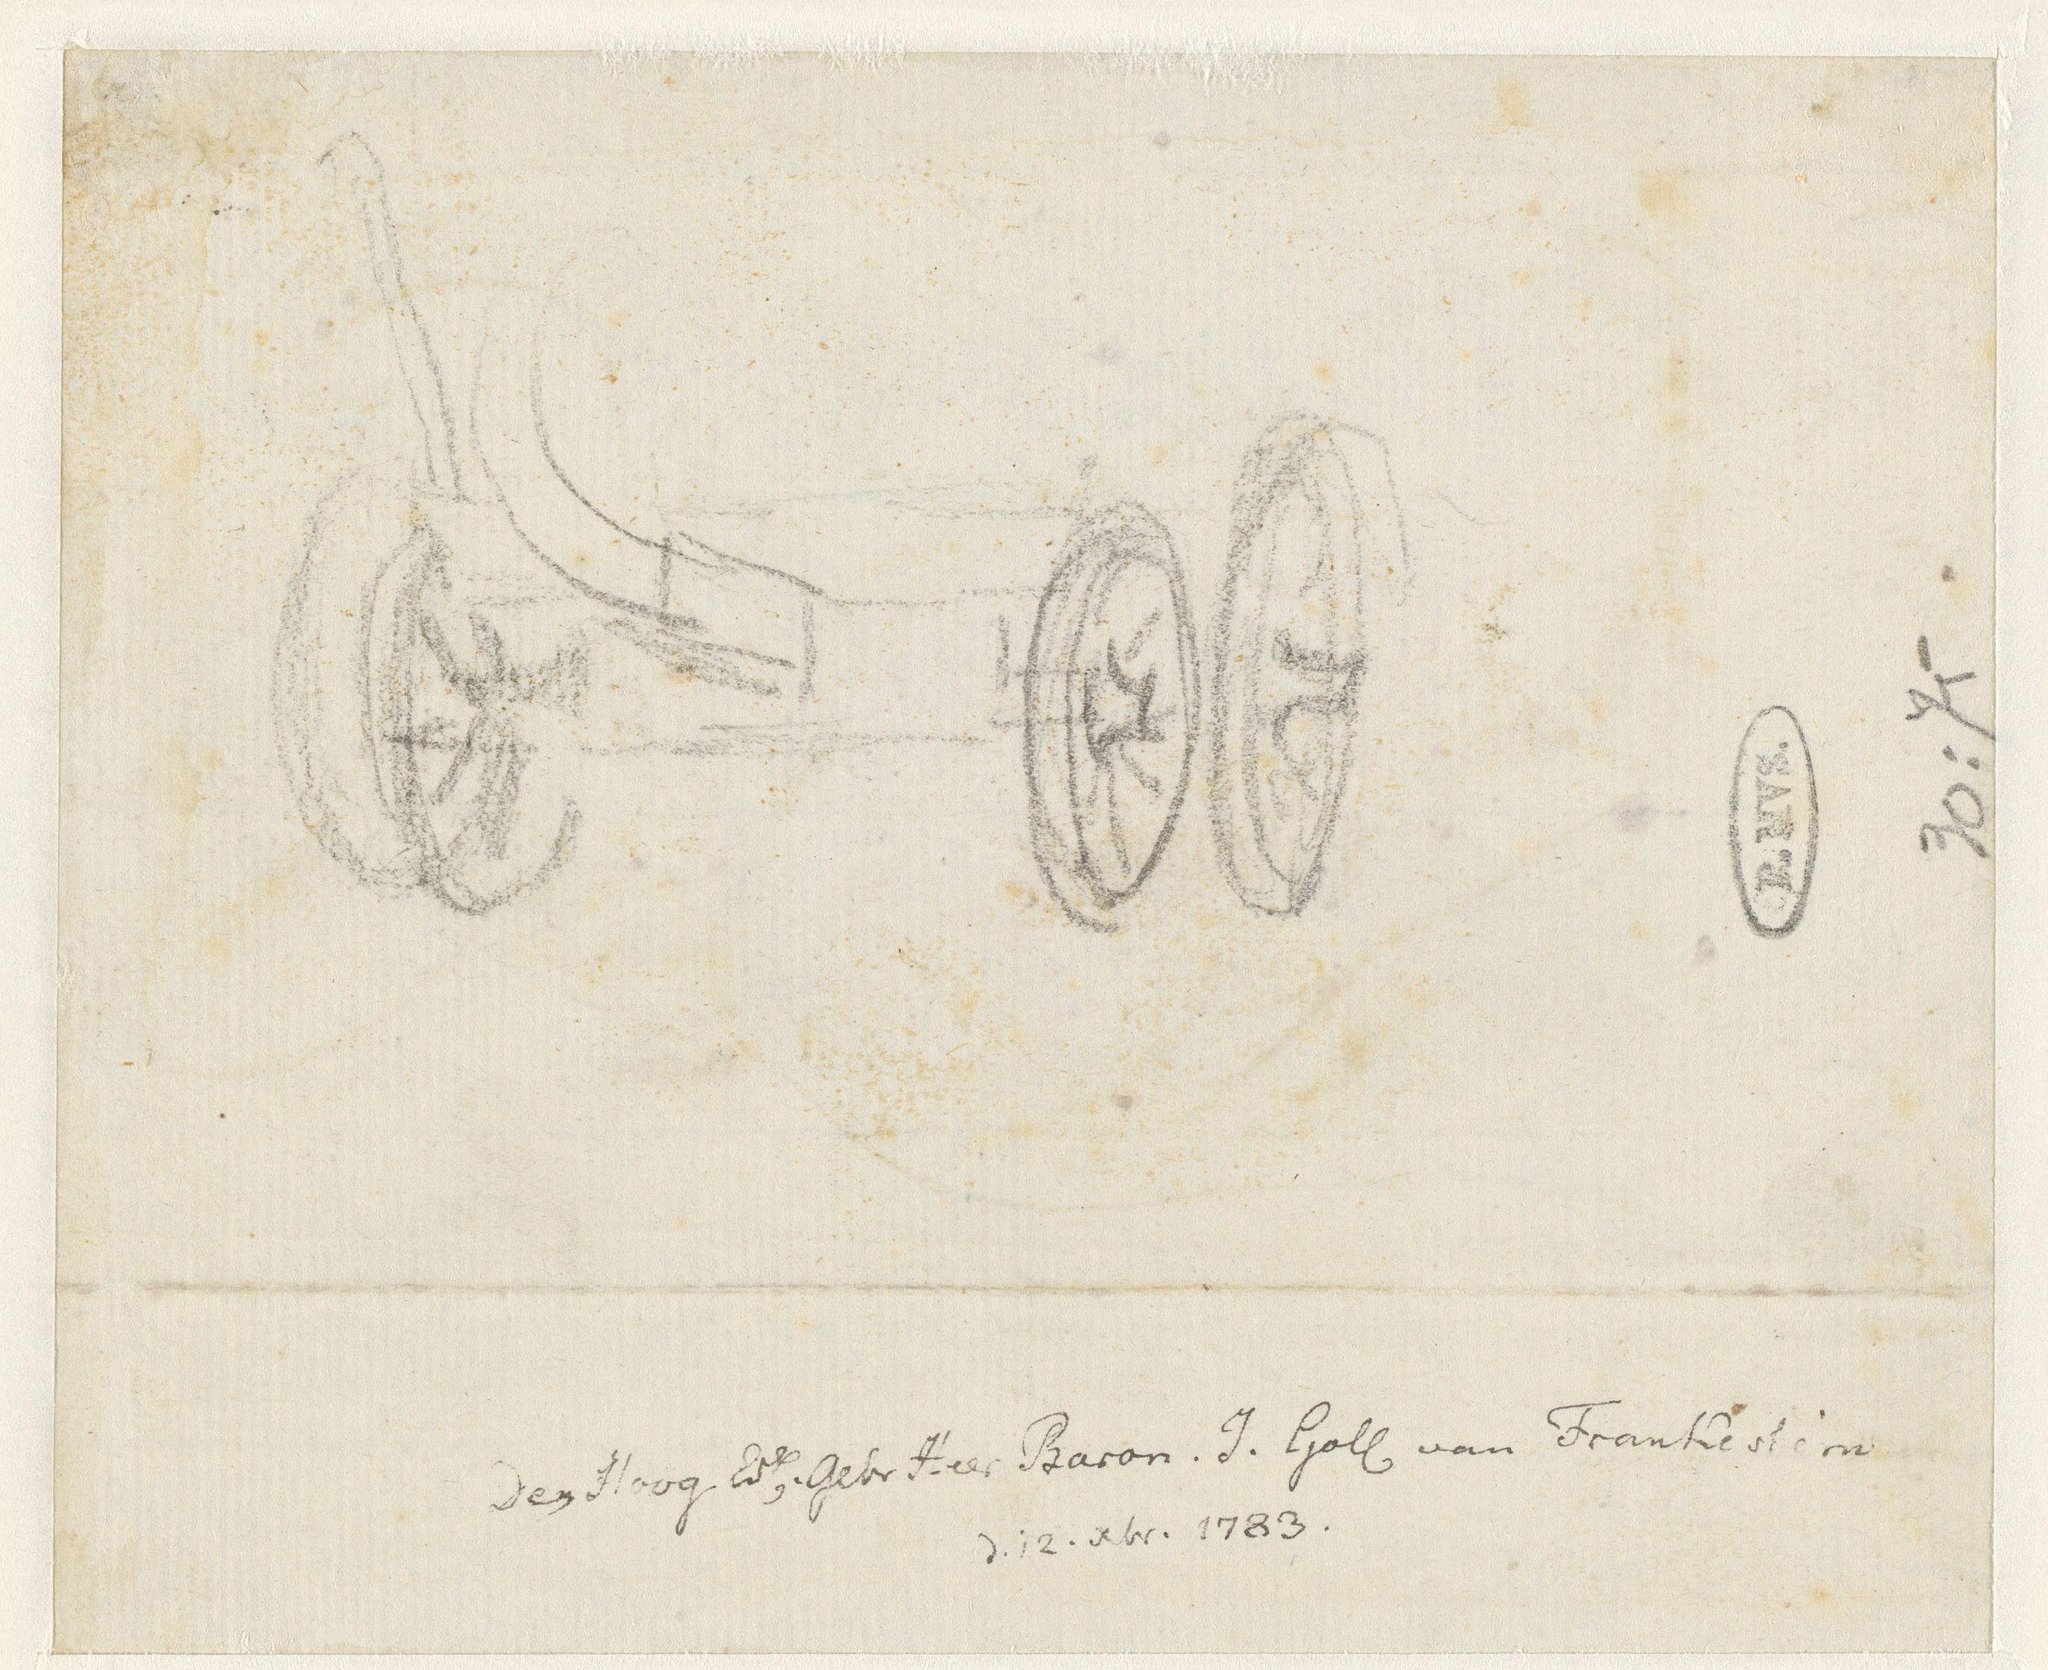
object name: drawing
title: Schets van een kar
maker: louis bernard coclers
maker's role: draughtsman, print maker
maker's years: 1741-1817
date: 1783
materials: chalk, paper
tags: (farm) wagon, freight wagon, cart